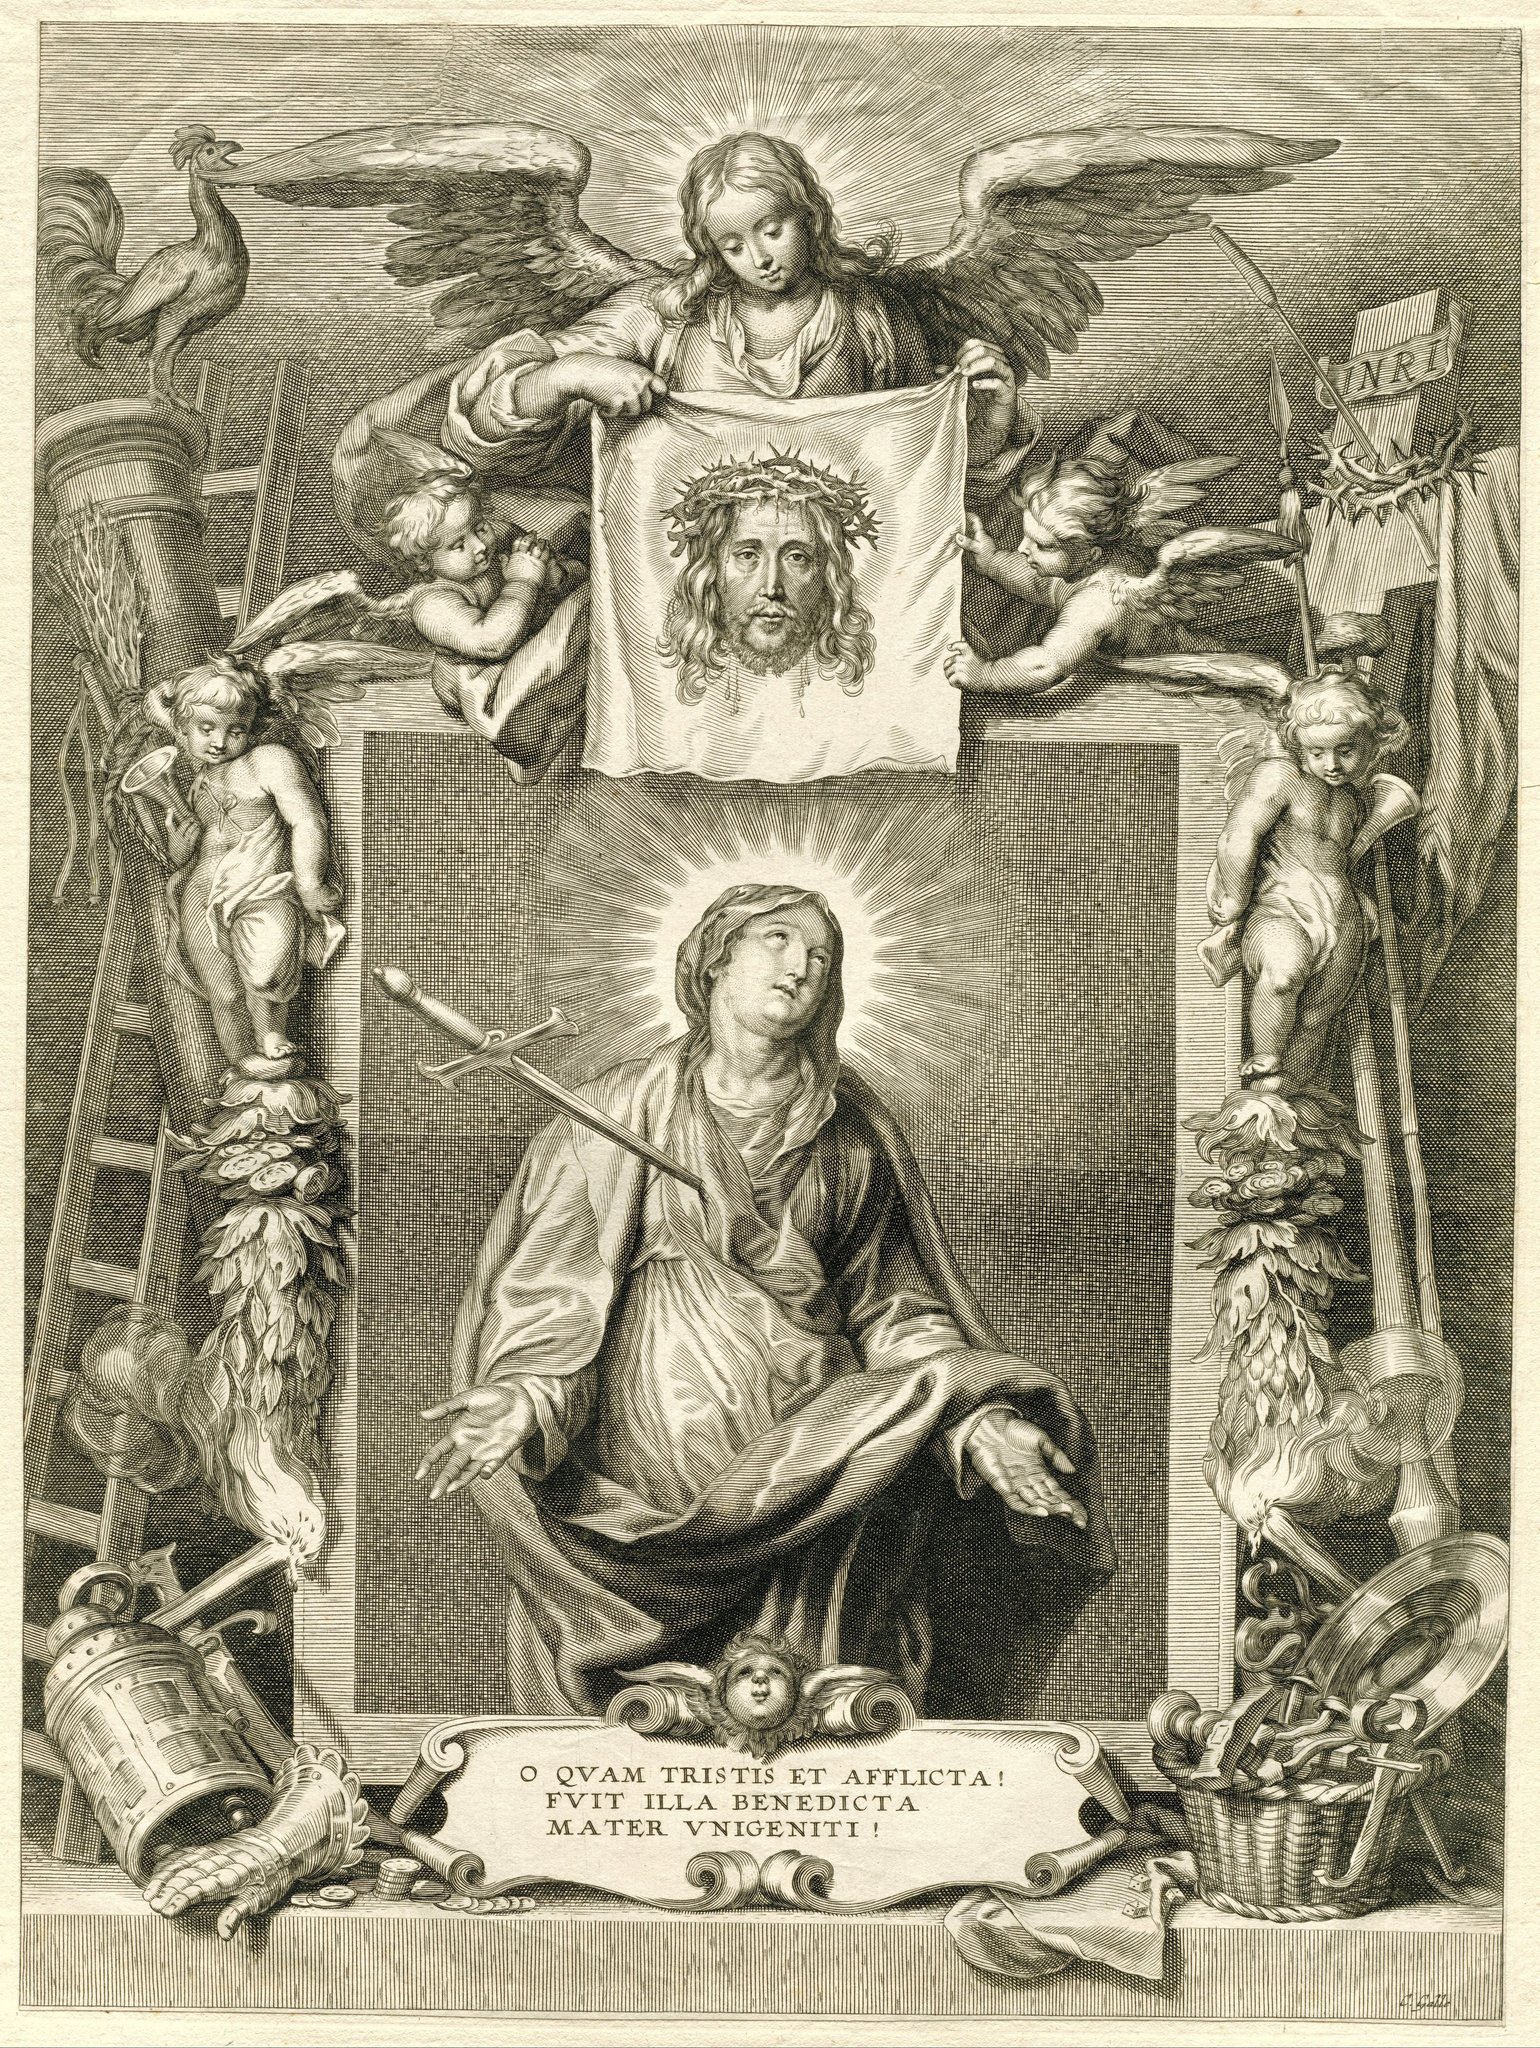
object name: print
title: Maria als Mater Dolorosa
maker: cornelis galle (ii)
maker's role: print maker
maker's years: 1615-1678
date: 1638-1678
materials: paper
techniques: engraving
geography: antwerp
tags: 'mater dolorosa', mary with the instruments of the passion, 'vera icon', 'sudarium', veronica-portrait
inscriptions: poem: ‘O quam tristis et aflicta / Fuit illa Benedicta / Mater Unigeniti !’, collector's mark: Lugt 240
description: Maria als Mater Dolorosa, met zwaard door de borst, opkijkend naar het gelaat van Christus met doornenkroon op de doek van Veronica (Vera Icon). Deze wordt vastgehouden door een engel. Scène omgeven door passiewerktuigen en engeltjes. Middenonder in cartouche drie regels uit het Stabat Mater: O quam tristis et aflicta / Fuit illa Benedicta / Mater Unigeniti!